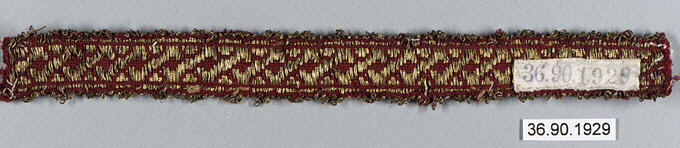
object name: galloon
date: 1801-1900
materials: metal thread, silk